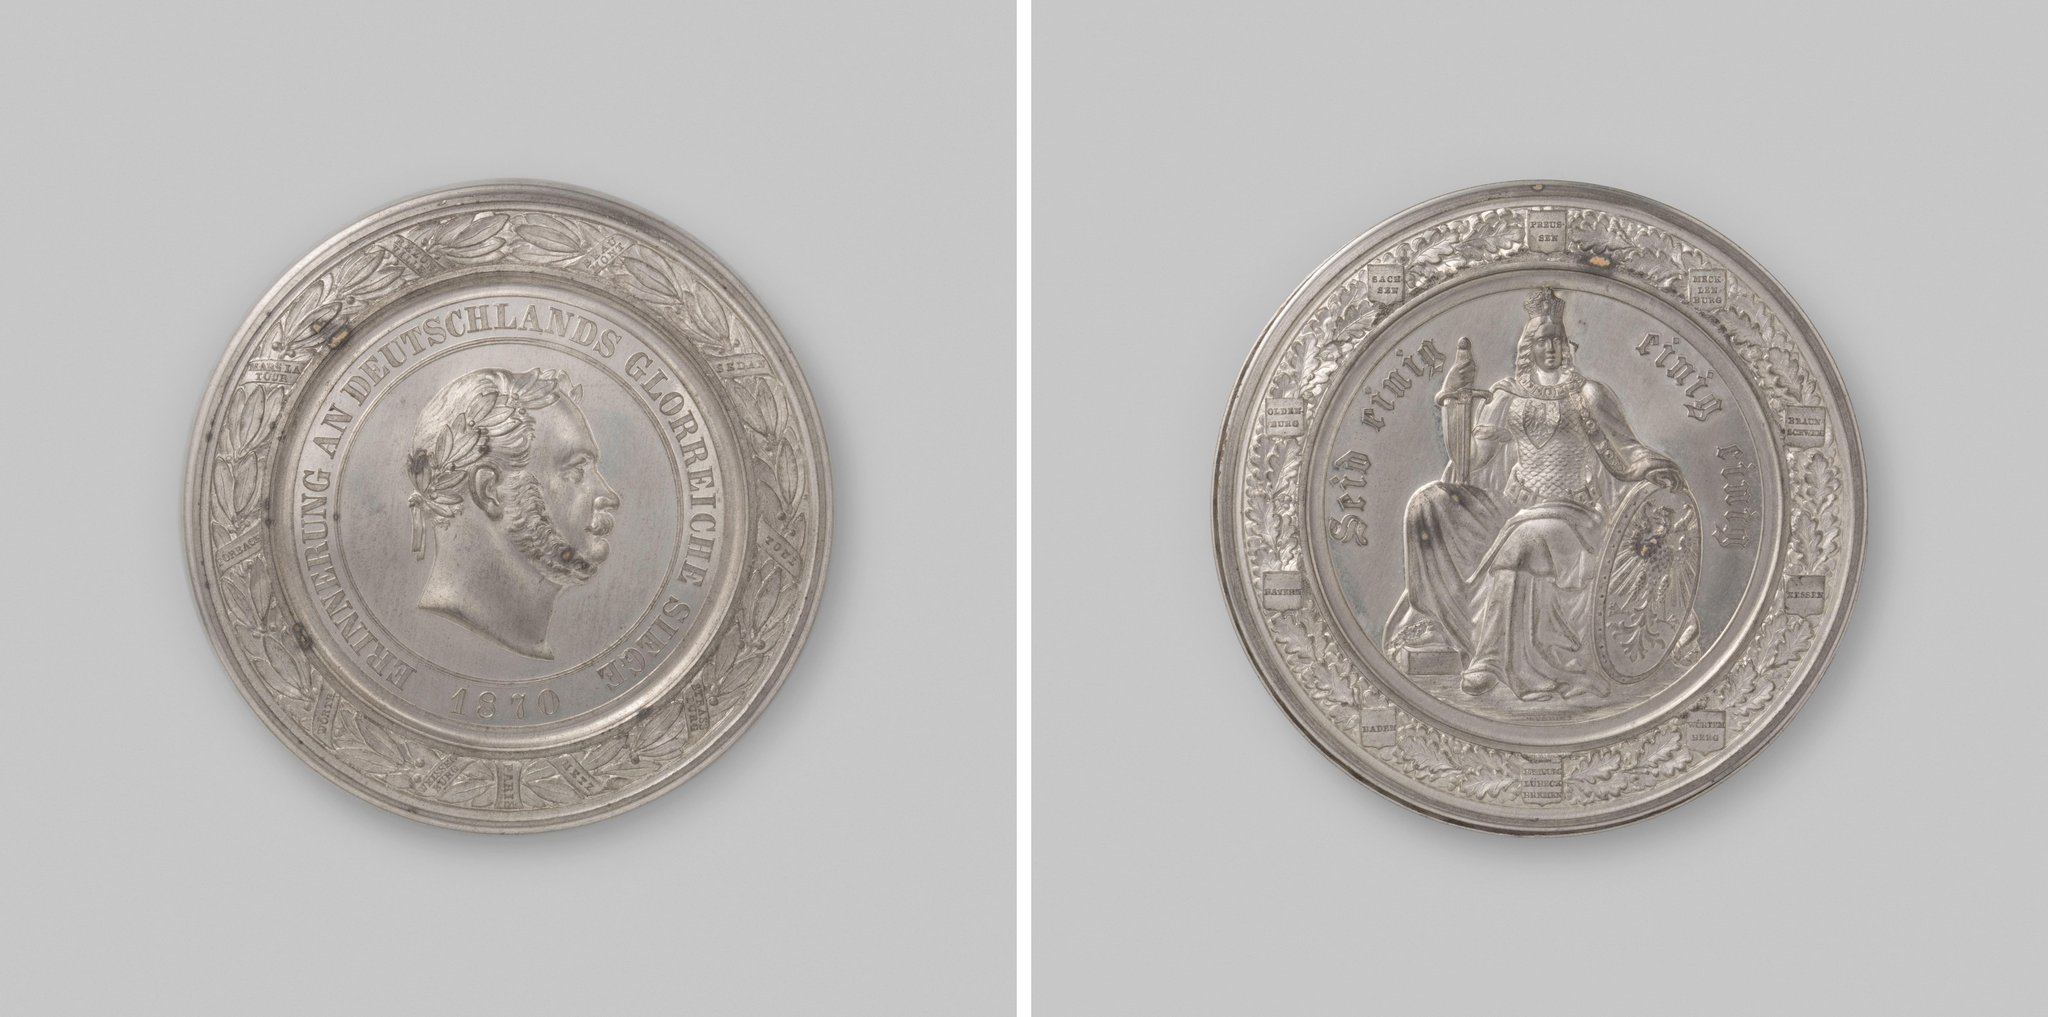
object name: history medal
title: Duitse overwinningen in de Frans-Pruisische oorlog, ter ere van Wilhelm I, koning van Pruisen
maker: Anonymous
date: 1870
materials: cardboard, tin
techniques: striking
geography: germany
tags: wilhelm i (keizer van duitsland), germany, france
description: Tinnen penning. Voorzijde: borststuk man met lauwerkrans binnen omschrift en lauwerkrans, omwonden met lint, waarop namen van belangrijkste Duitse overwinningen staan vermeld. Keerzijde: gekroonde vrouw met zwaard en schild, voorstellende Germania binnen omschrift in Gothisch schrift en eikekrans, waarin tien schilden met namen van Duitse staten zijn verwerkt; inhoud: tien gedrukte plaatjes: Voorzijde: afbeelding van militaire operaties. Keerzijde: opschrift.